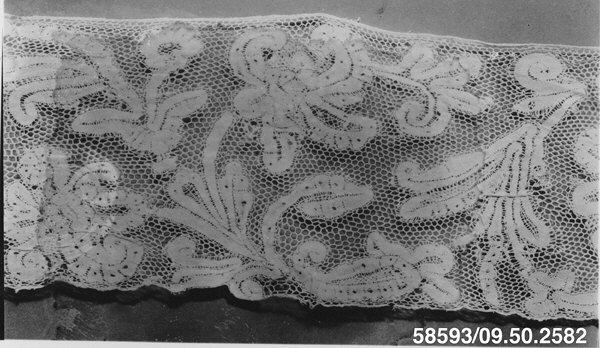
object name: strip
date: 1701-1733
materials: lace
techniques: lace